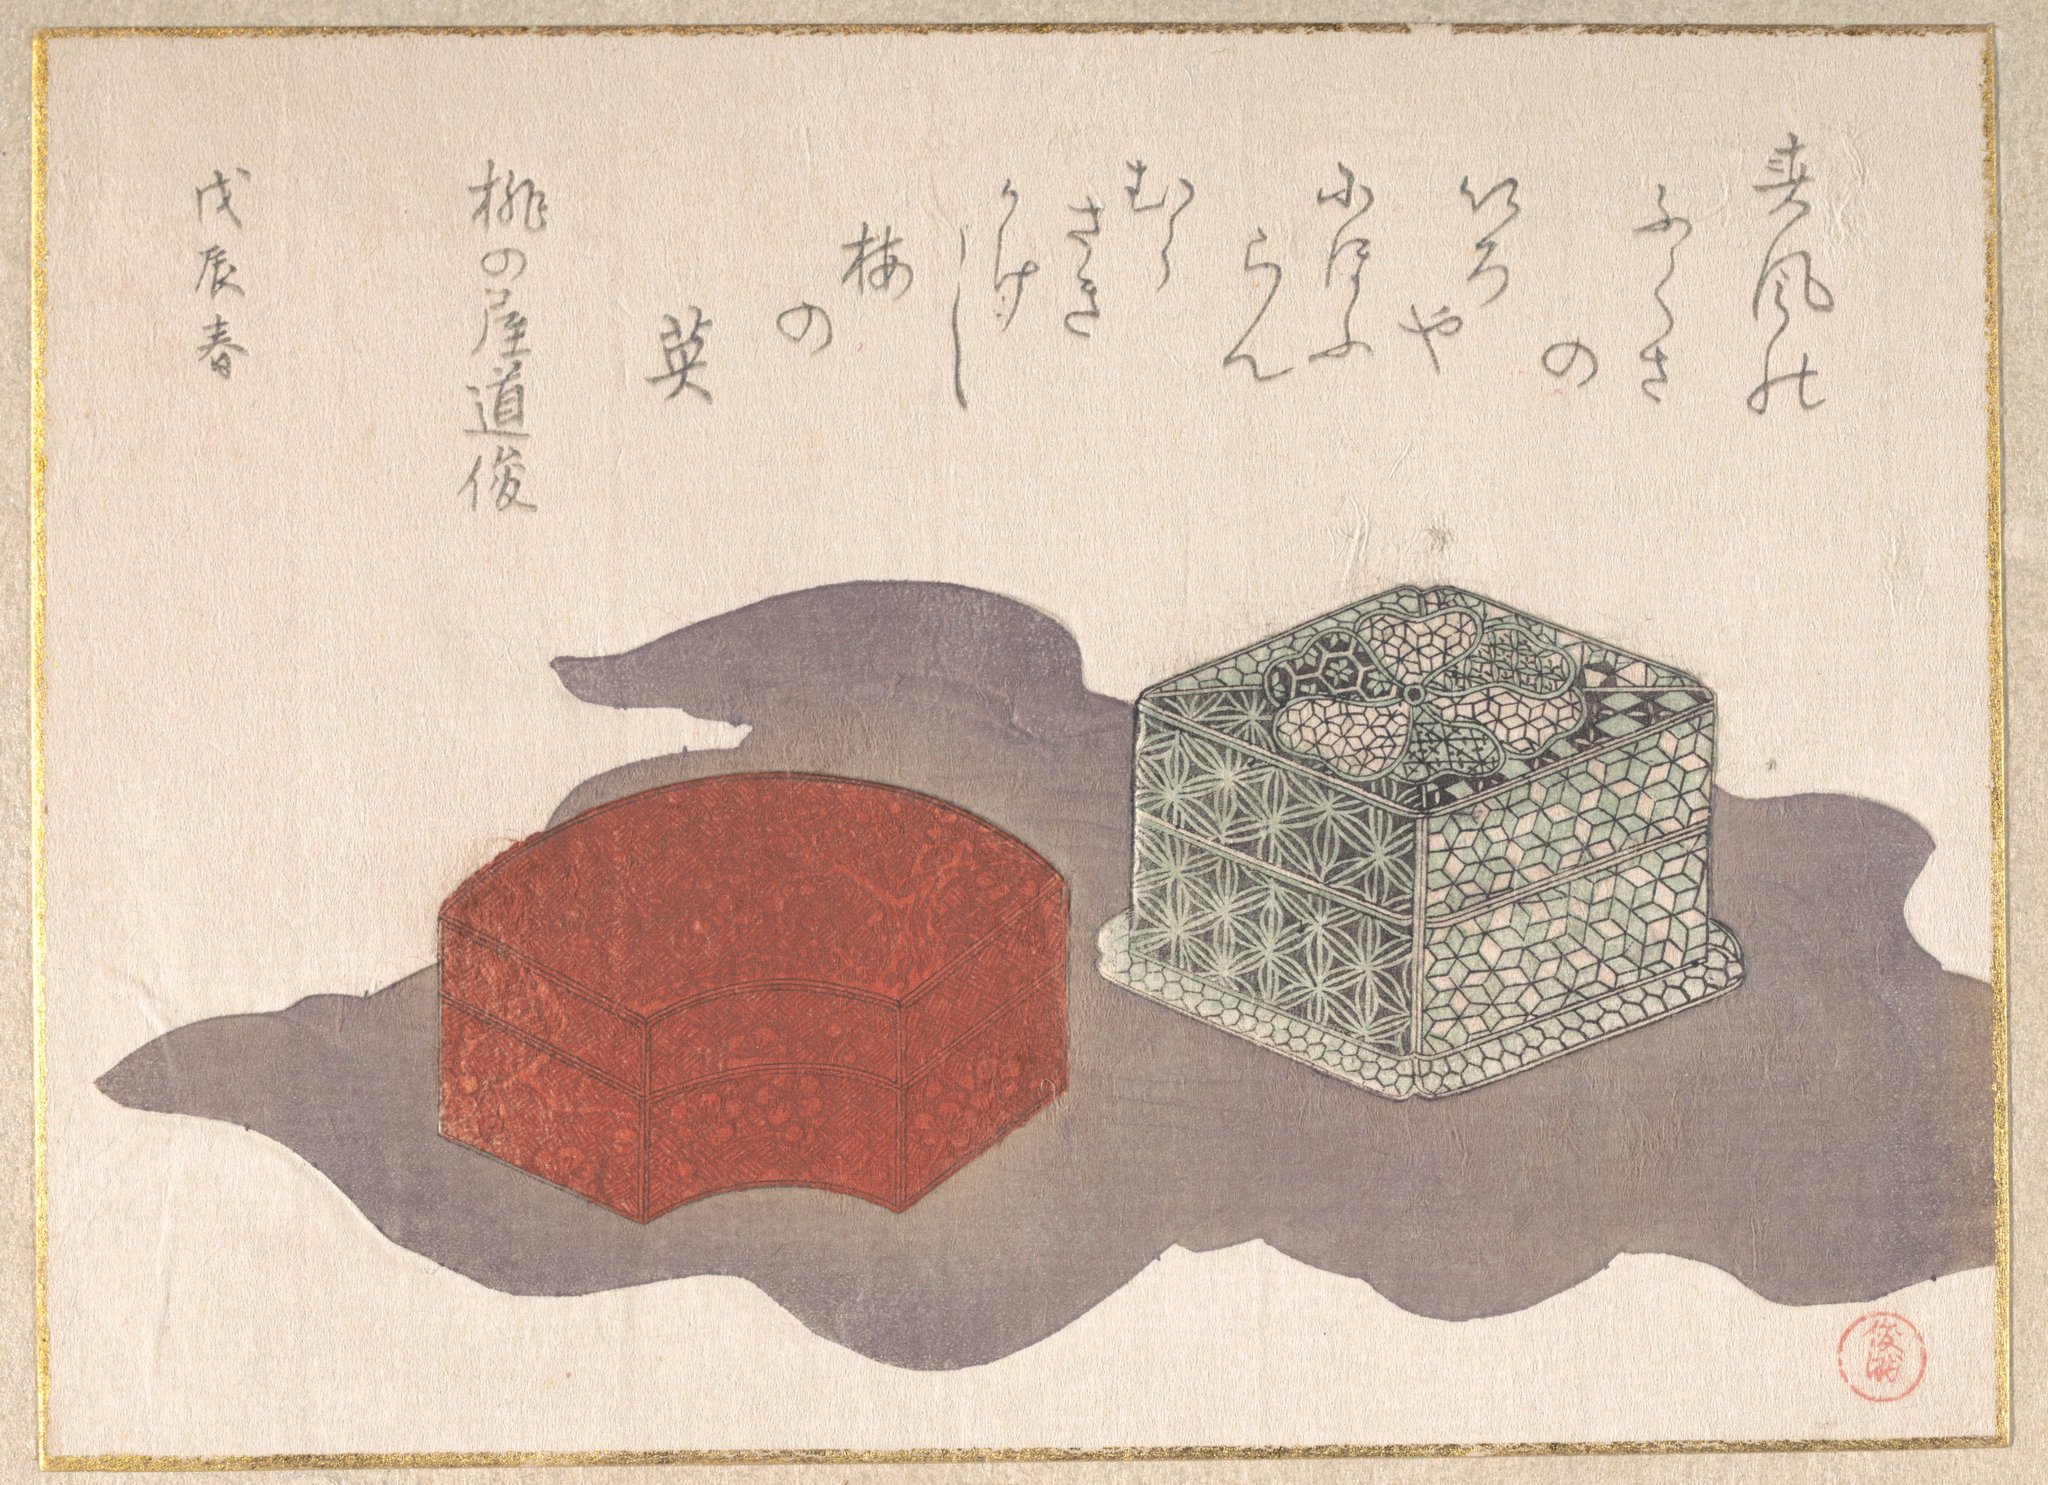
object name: woodblock print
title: Incense Boxes with a Wrapping Cloth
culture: japanese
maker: kubo shunman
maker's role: artist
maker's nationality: japanese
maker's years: 1757-1820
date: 1808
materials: ink, paper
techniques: surimono, woodblock print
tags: boxes